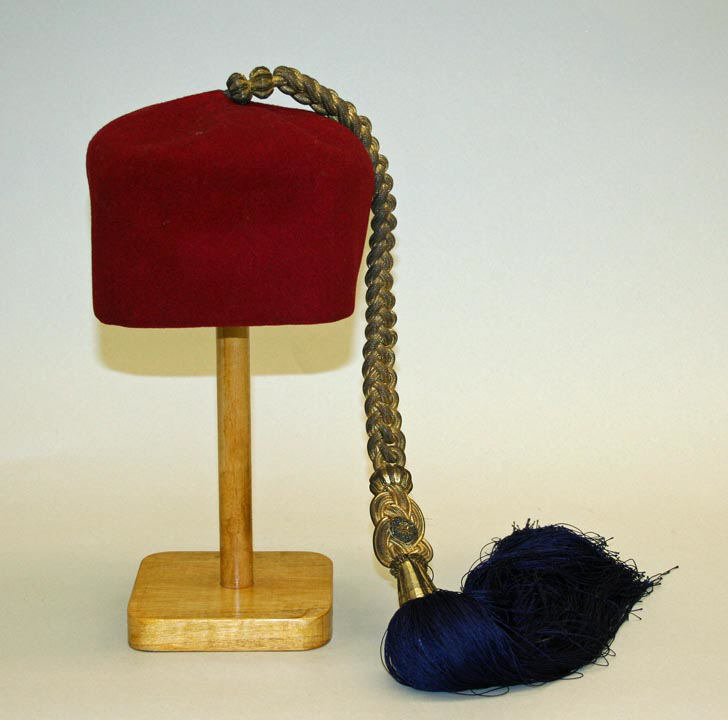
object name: cap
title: Lady's Féssi Cap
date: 1850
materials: metal thread, silk, wool